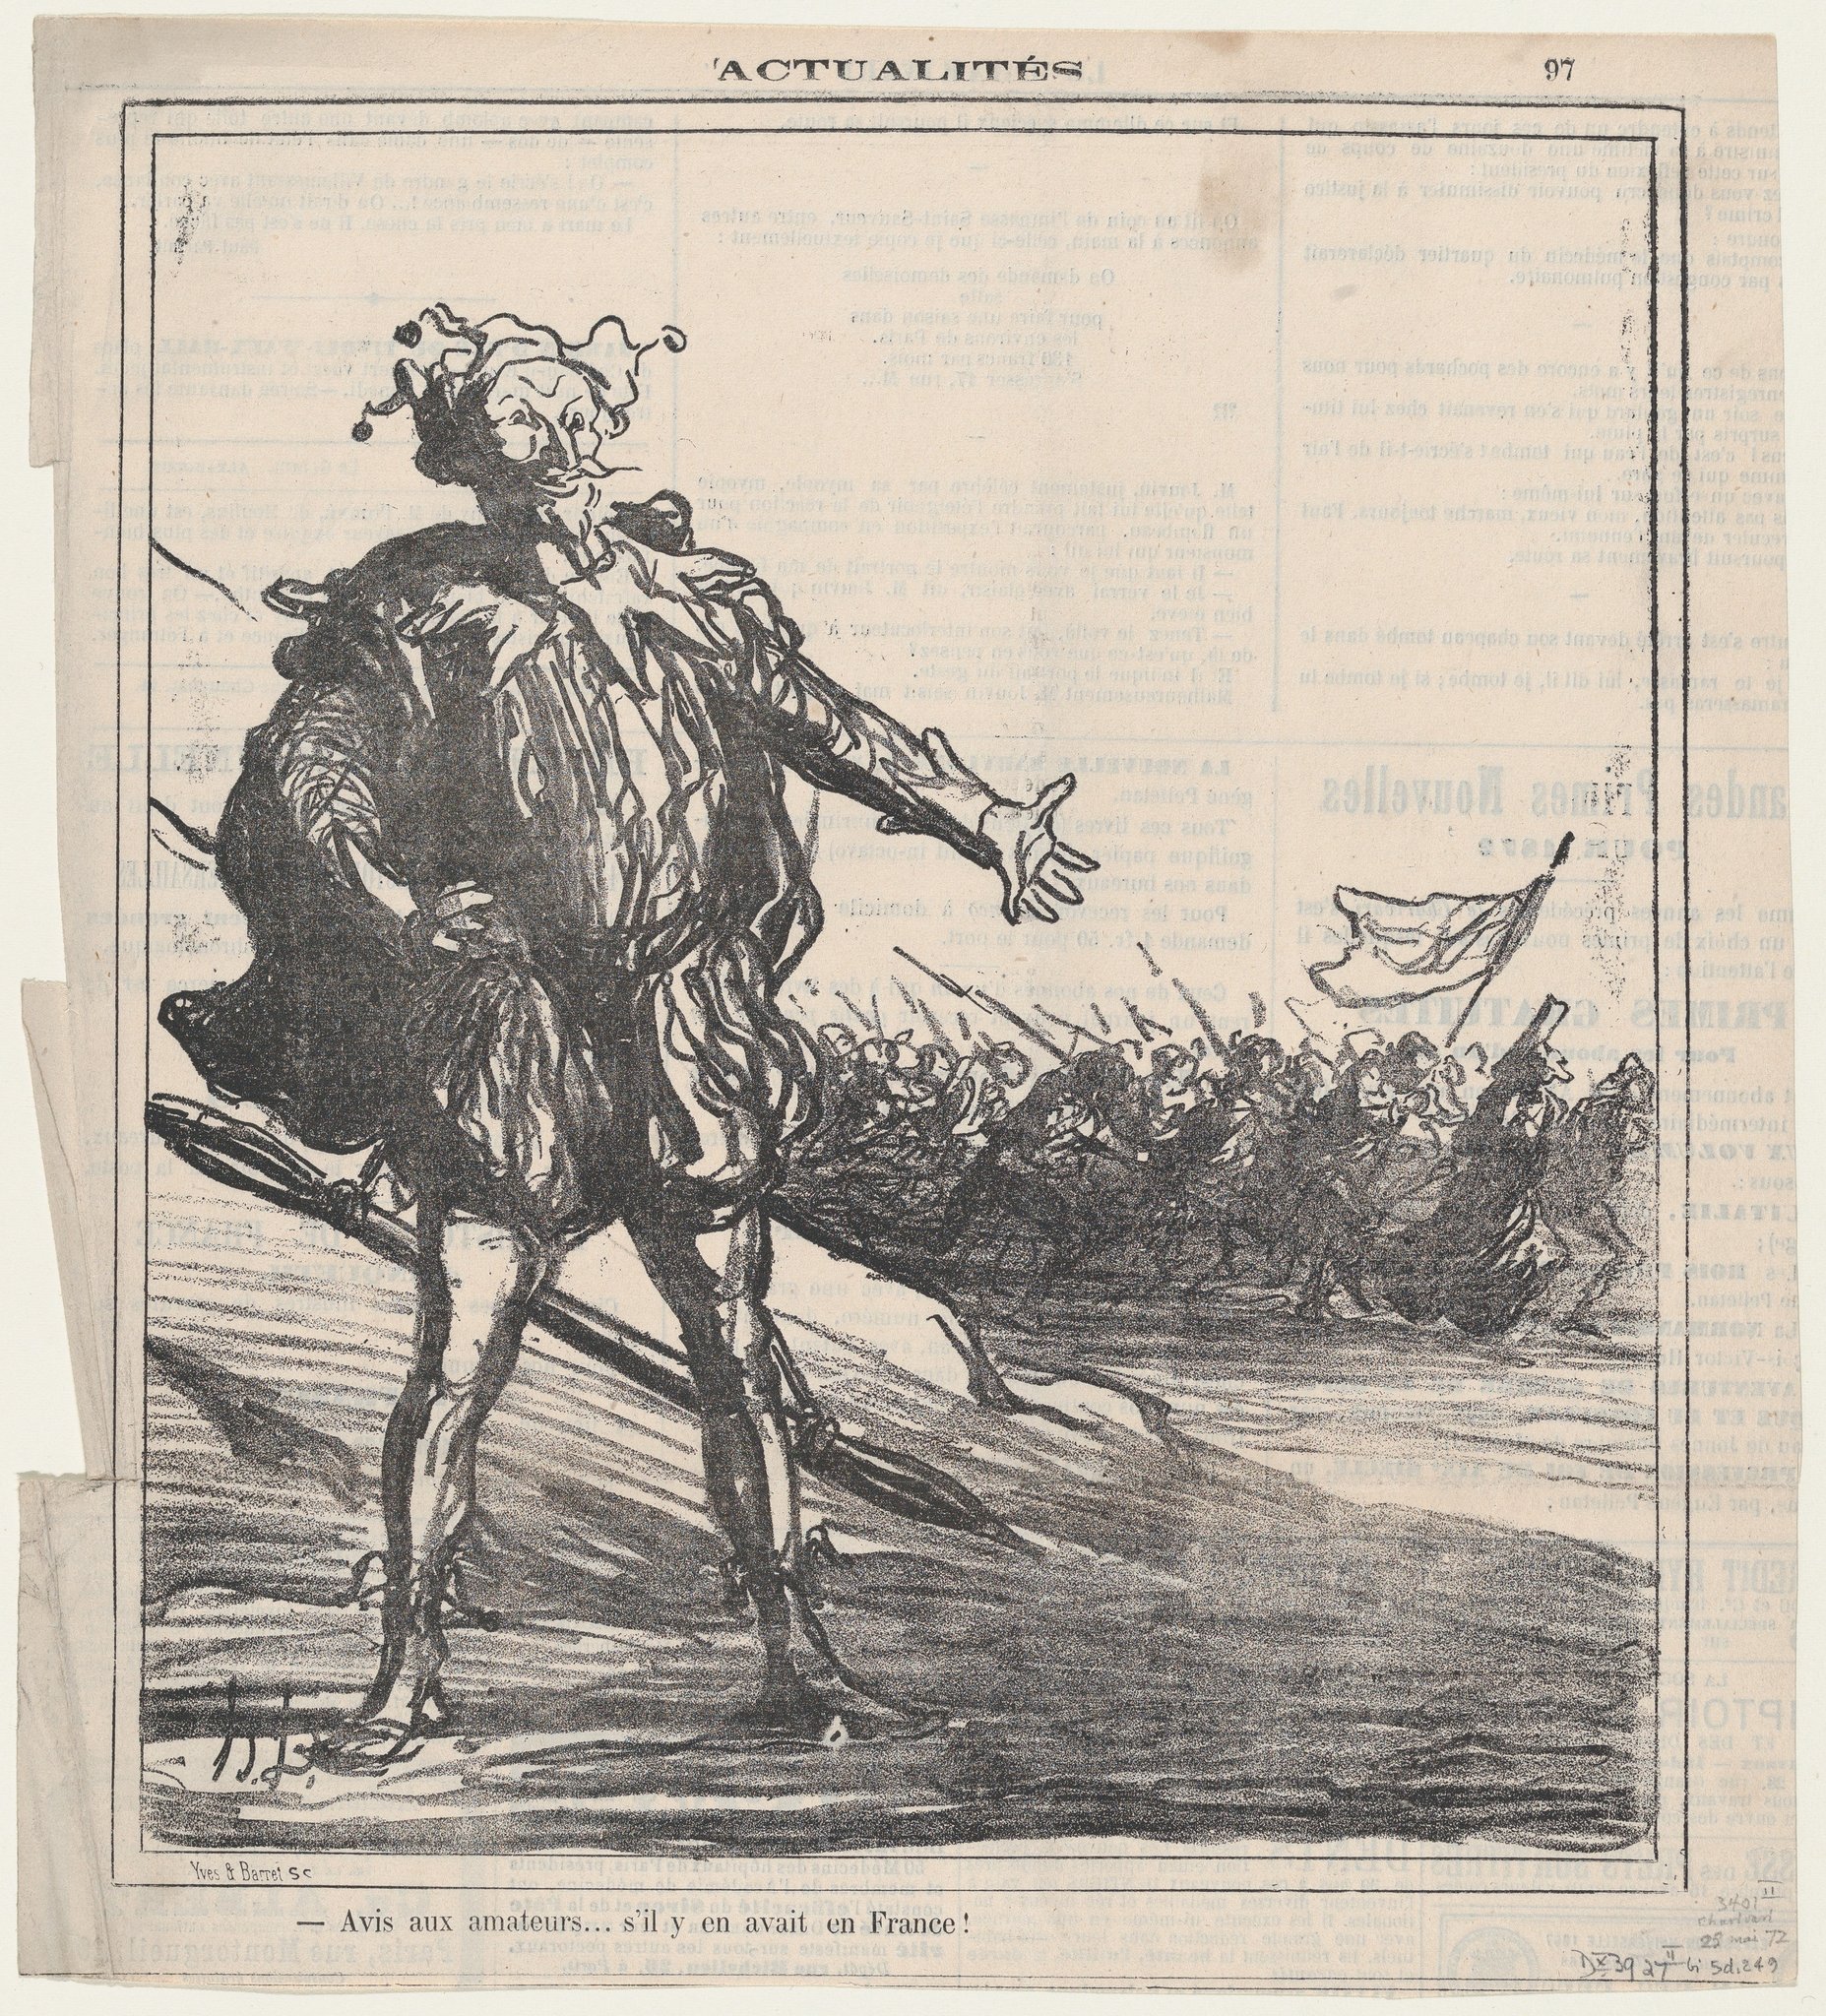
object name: print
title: Notice to connoisseurs.... in case there are any left in France!, from 'News of the day,' published in Le Charivari, May 25, 1872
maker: honoré daumier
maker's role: artist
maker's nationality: french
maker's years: 1808-1879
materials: paper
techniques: lithograph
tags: satire,soldiers,men,crowd